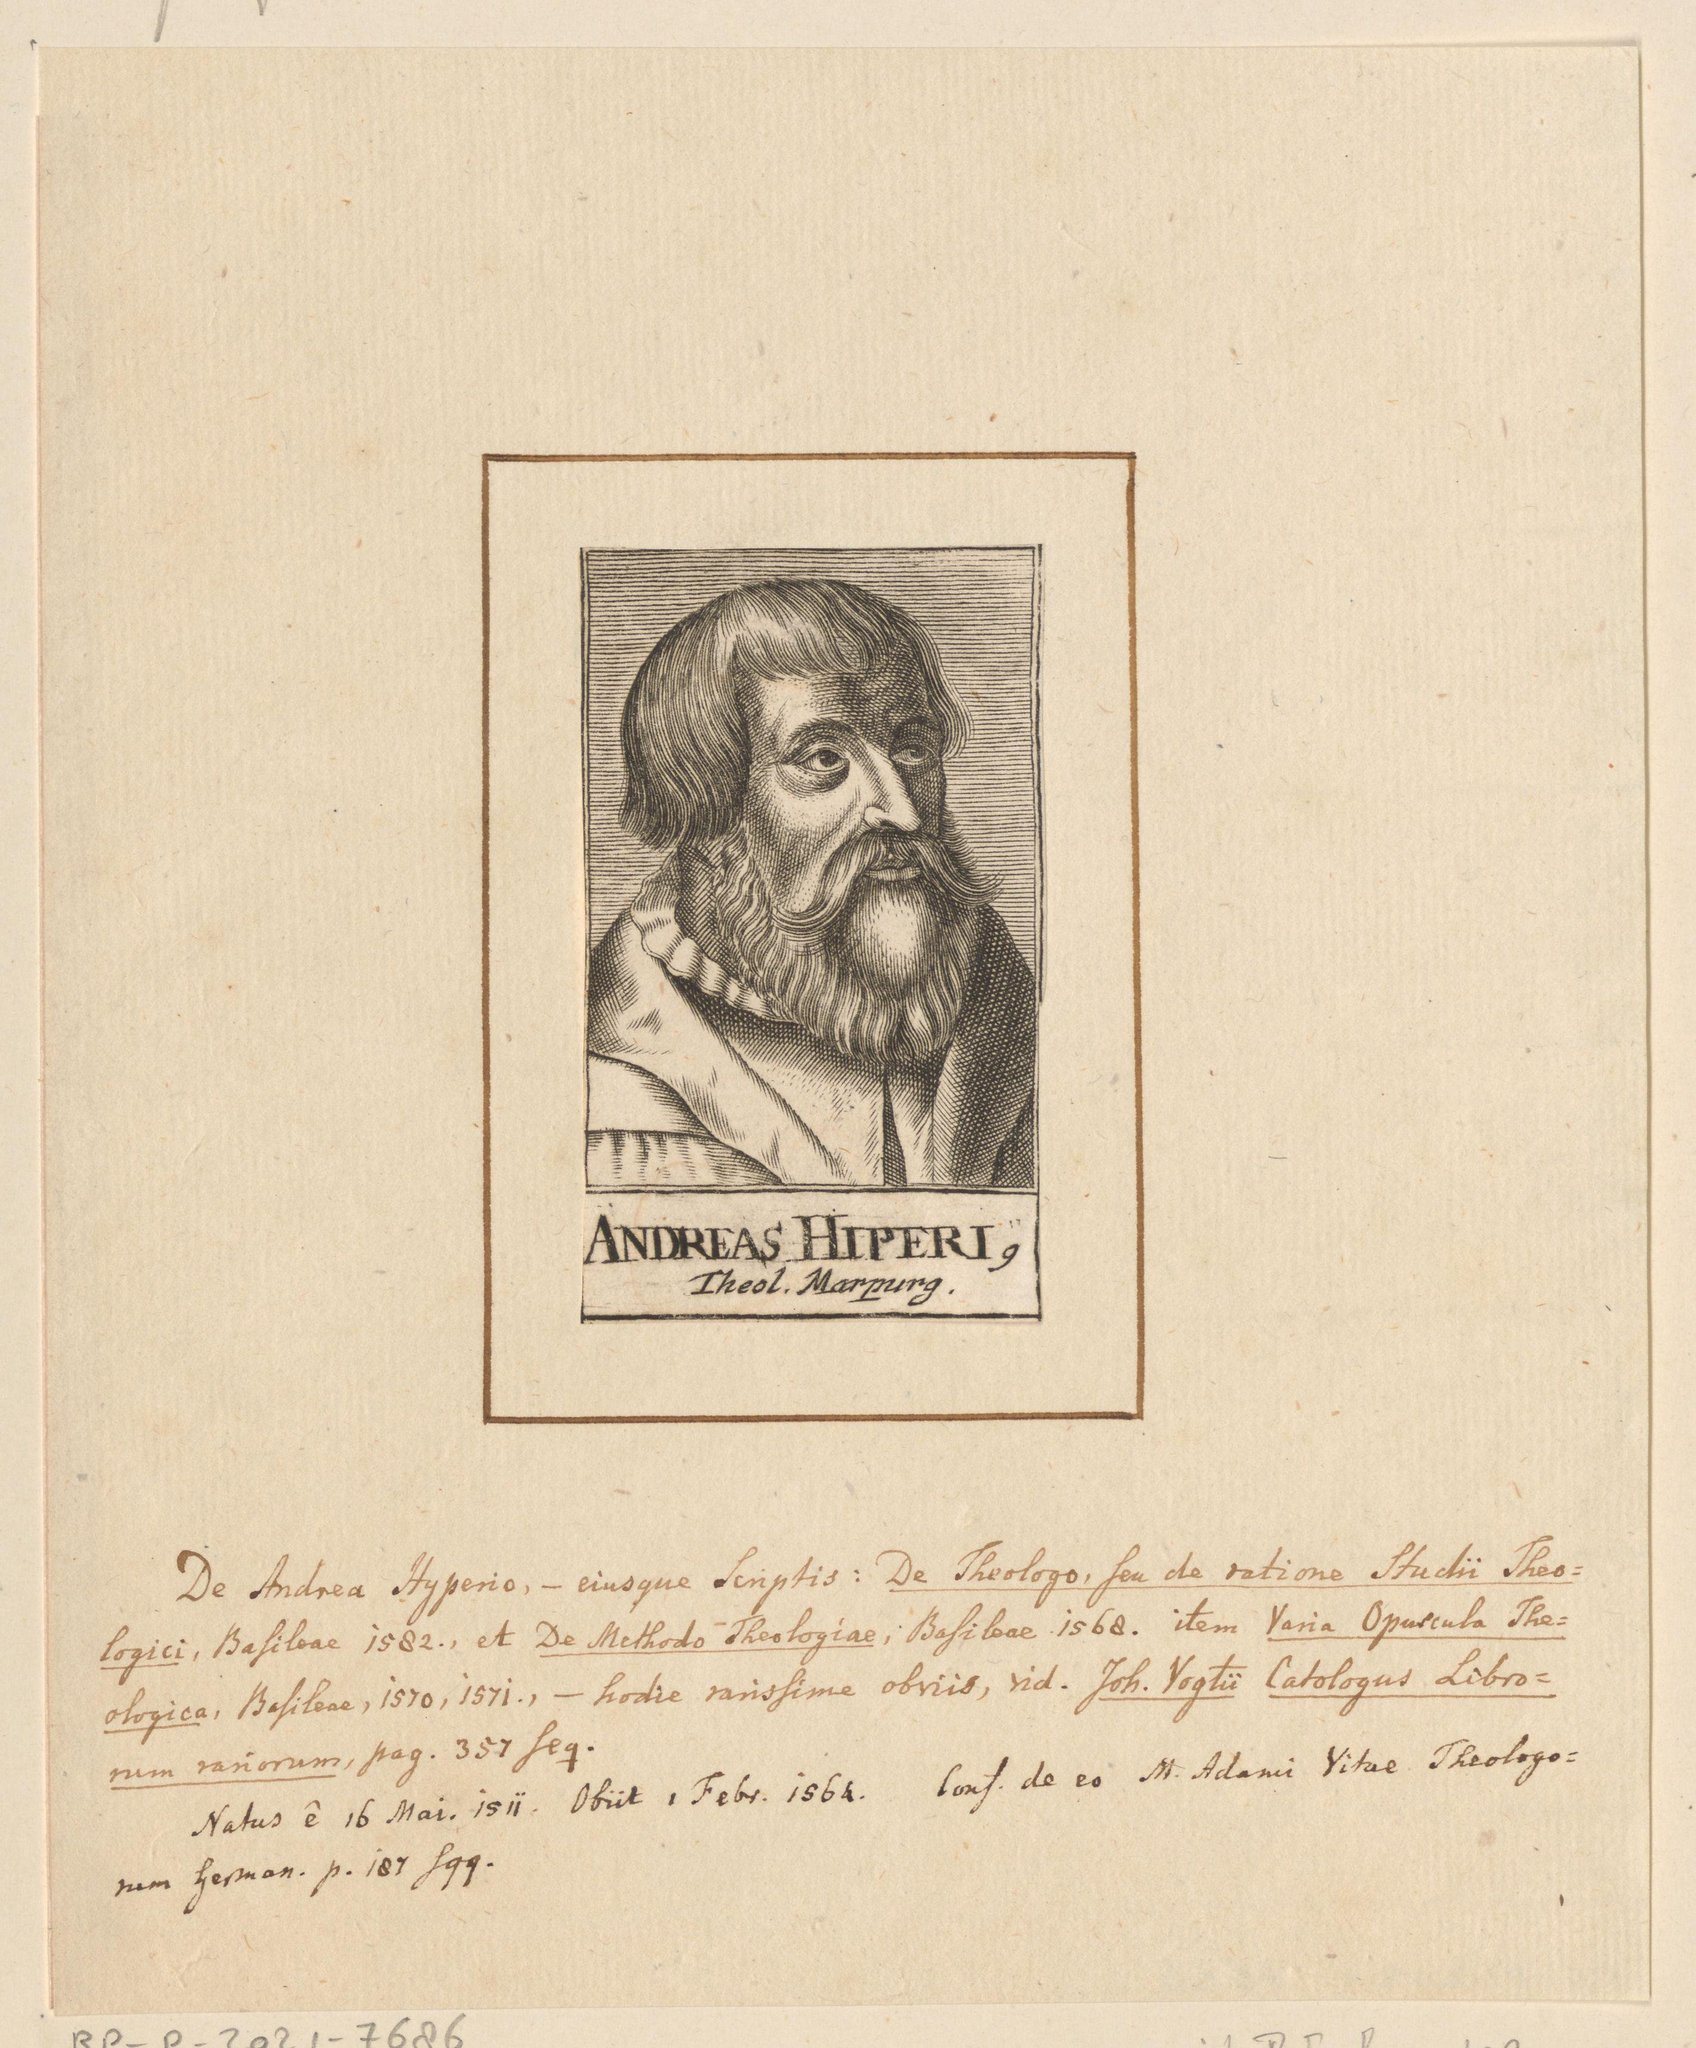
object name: print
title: Portret van Andreas Hyperius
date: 1688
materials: paper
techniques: engraving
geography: nuremberg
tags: theologian, historical persons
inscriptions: inscription: ‘De Andrea Hyperio, - eiusque scriptis : (...)’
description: Prent uit: Freher, Paul. Theatrum virorum eruditione clarorum. Neurenberg: Johann Hoffmann, 1688.